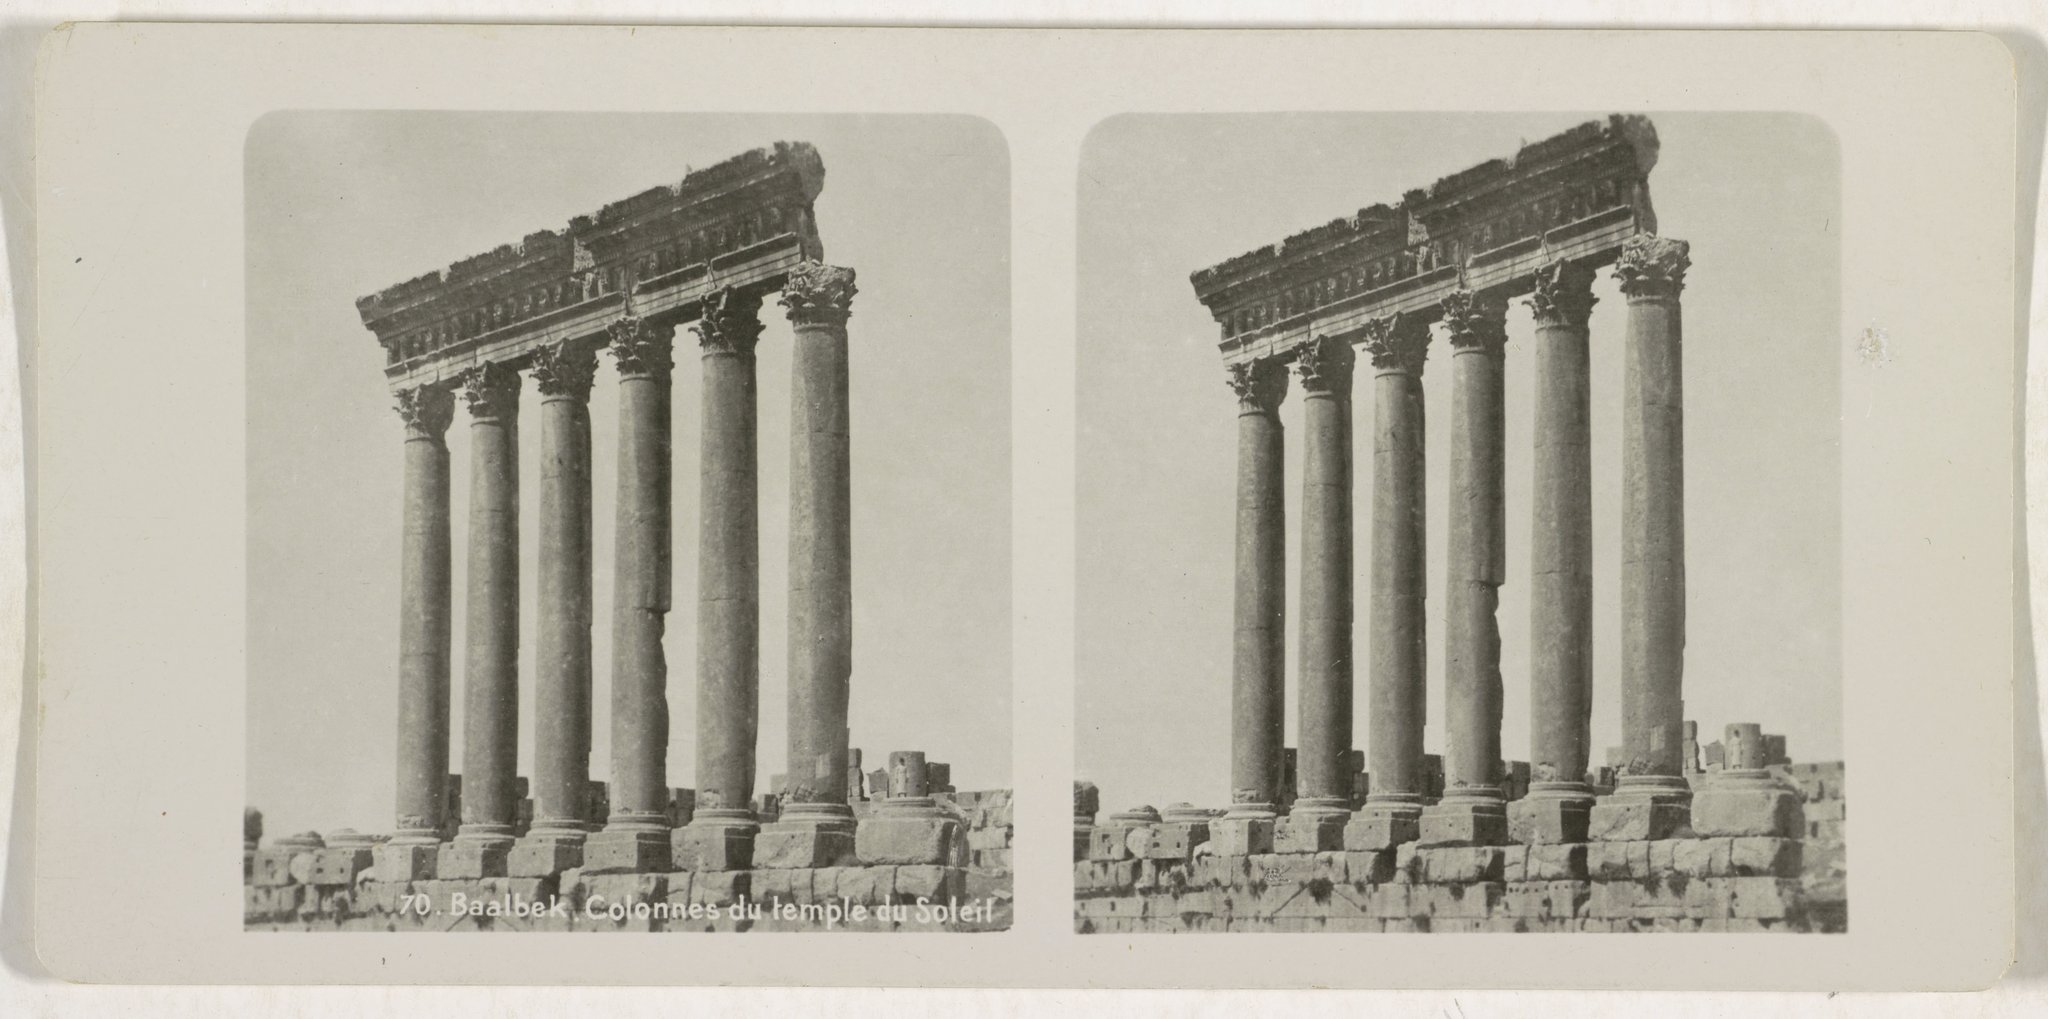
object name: stereograph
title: Baalbek, Colonnes du temple du Soleil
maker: richard sochor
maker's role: painter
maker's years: 1867-1925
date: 1903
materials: paper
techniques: gelatin silver print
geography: haarlem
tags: column, pillar ~ architecture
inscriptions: number: ‘70.’, monogram, inscription: ‘Déposé.’, address: ‘Parklaan 49/ HAARLEM/ (Holland)’, inscription: ‘Deze stereo-foto's worden in den handel gebracht en en gros en/ en détail verkocht door de ......... (...)’